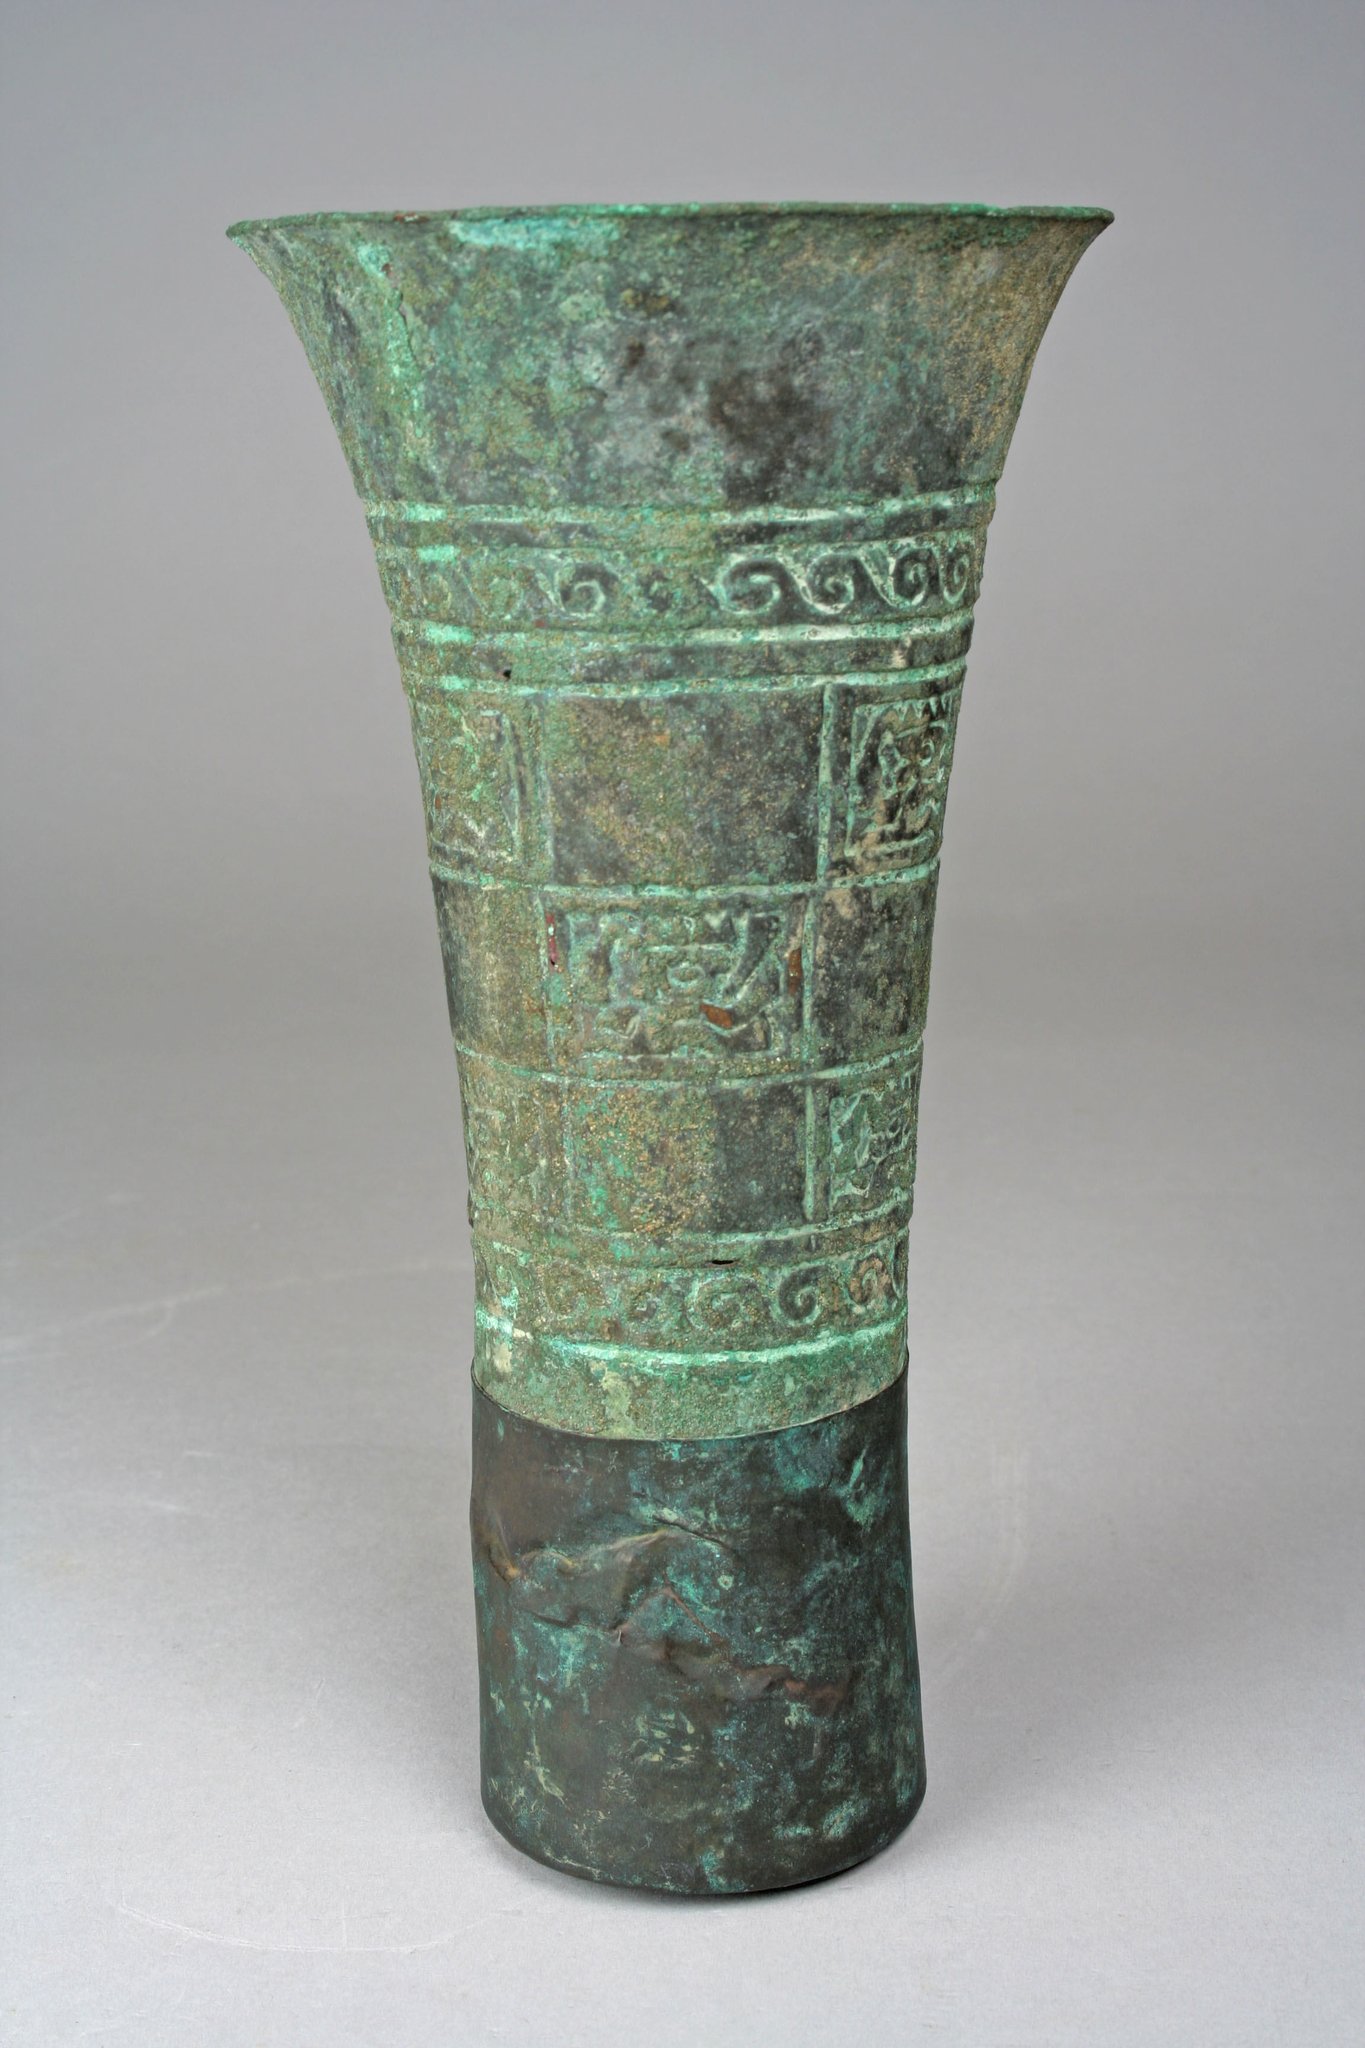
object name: beaker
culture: chimú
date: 1101-1500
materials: silver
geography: peru